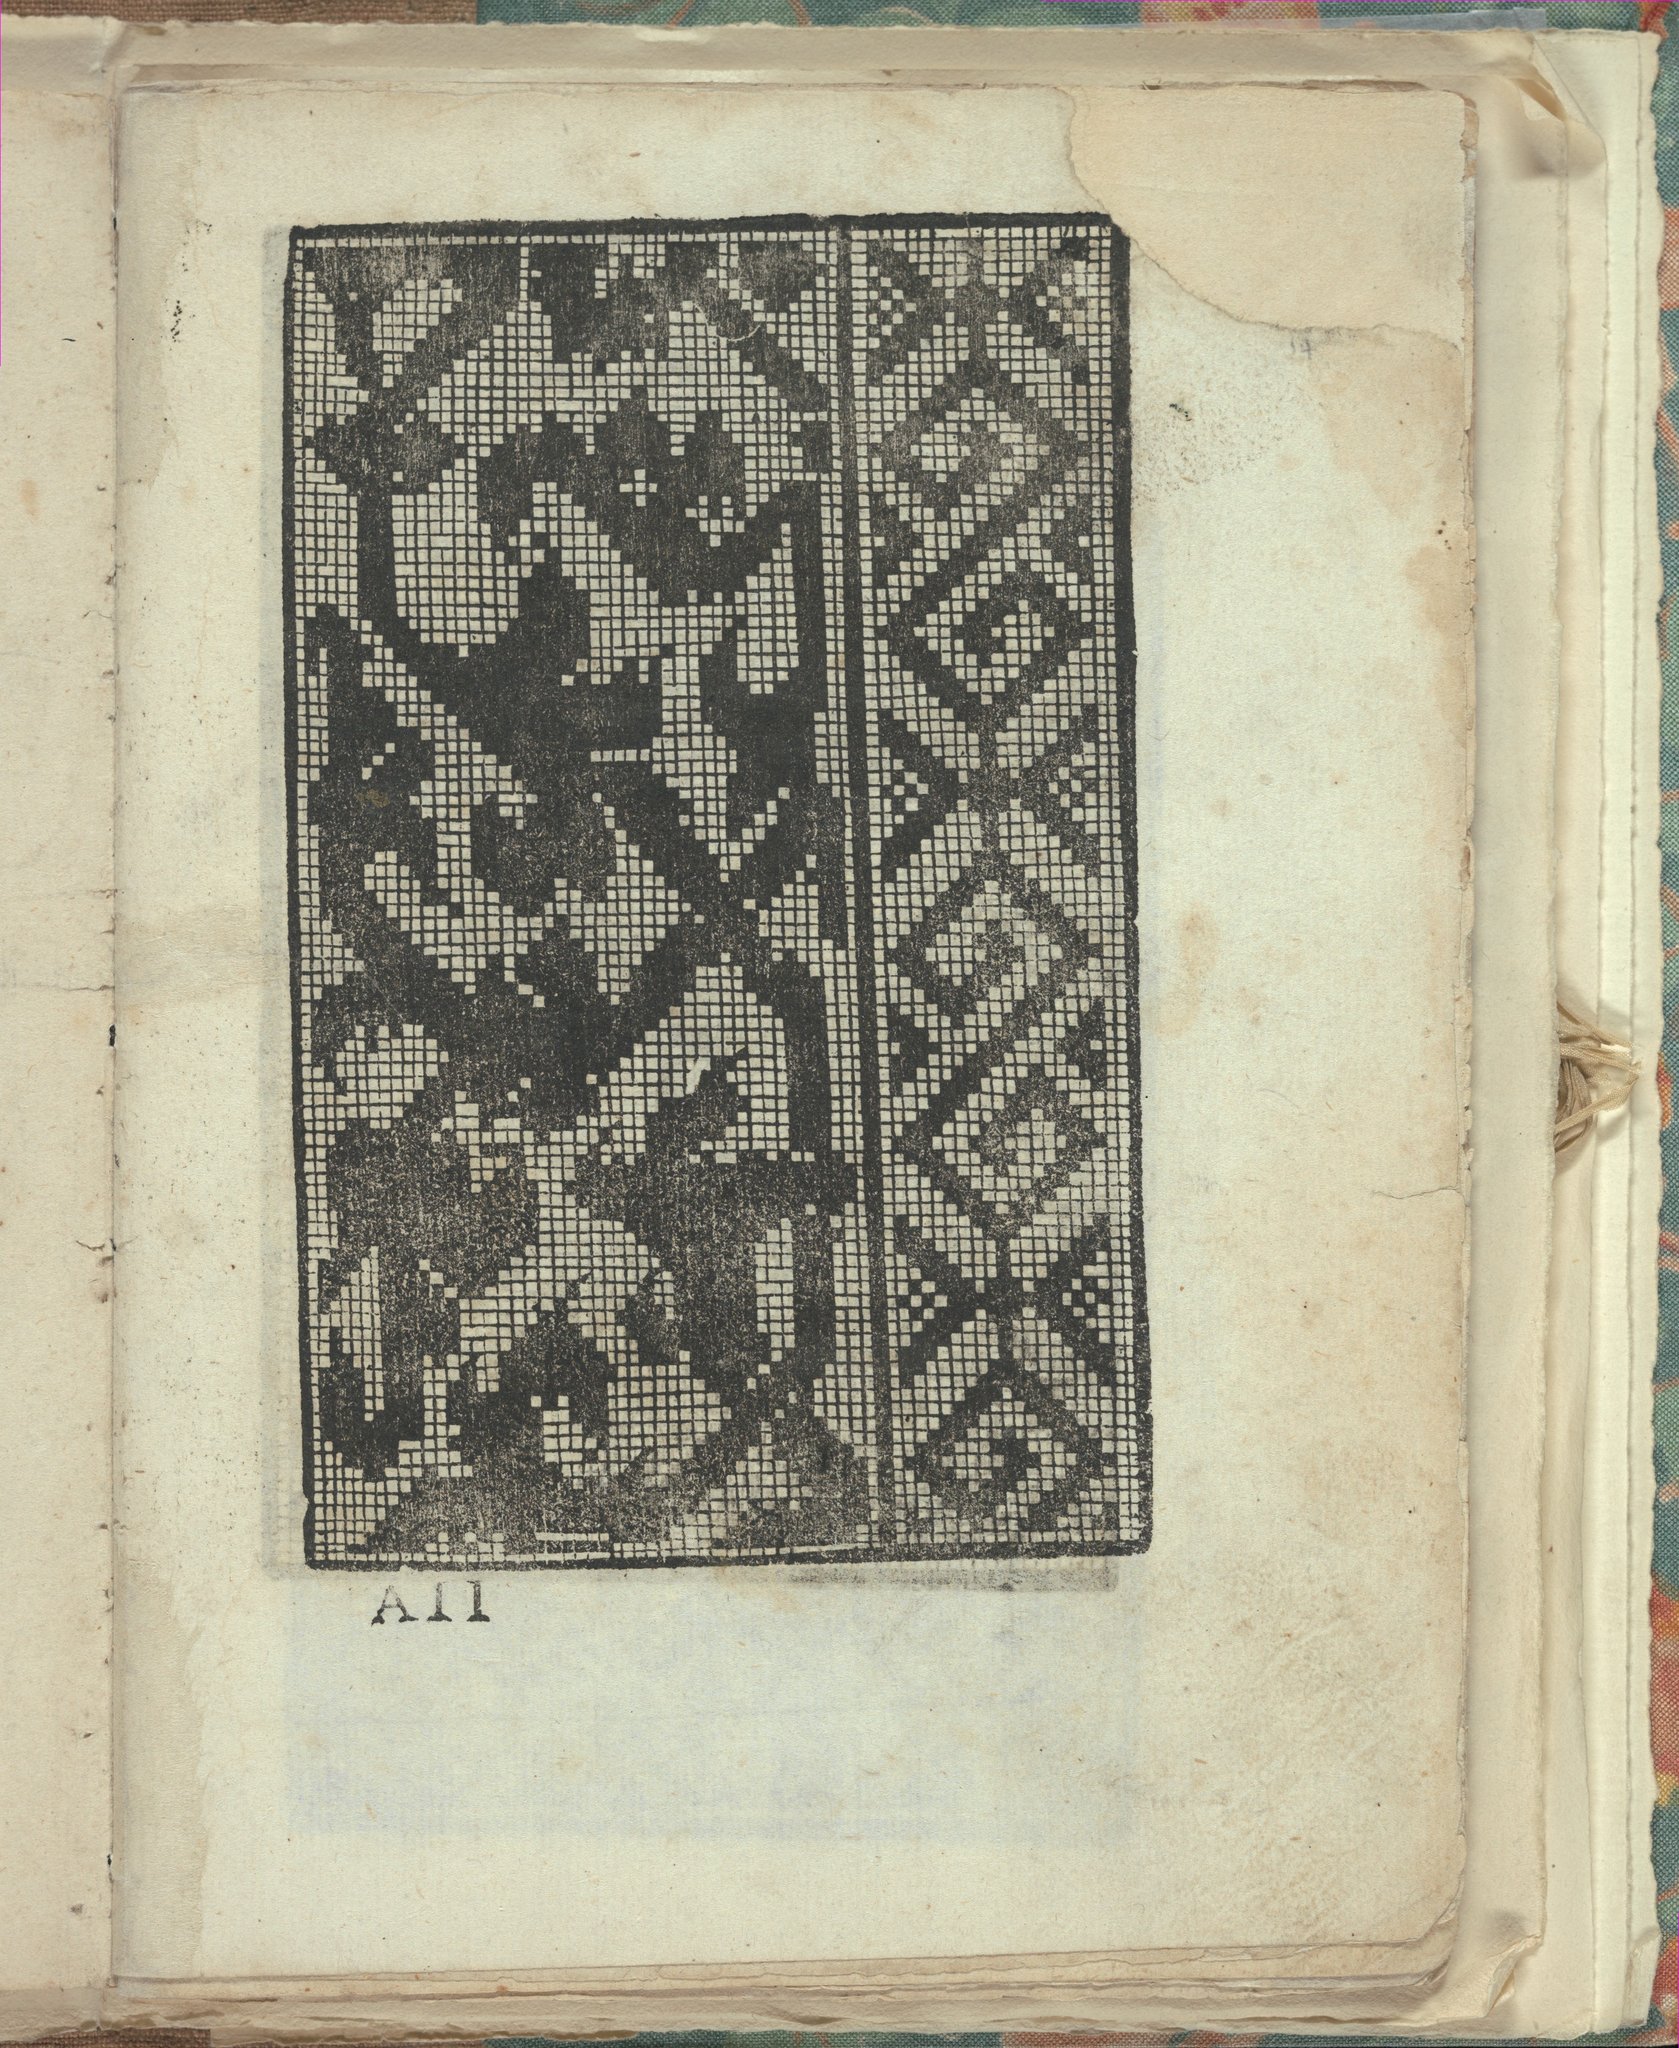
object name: book print ornament architecture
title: Opera Nova Universali intitulata Corona di racammi, page 14 (recto)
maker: giovanni andrea vavassore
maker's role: publisher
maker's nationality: italian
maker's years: 1530-1573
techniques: woodcut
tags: ornament